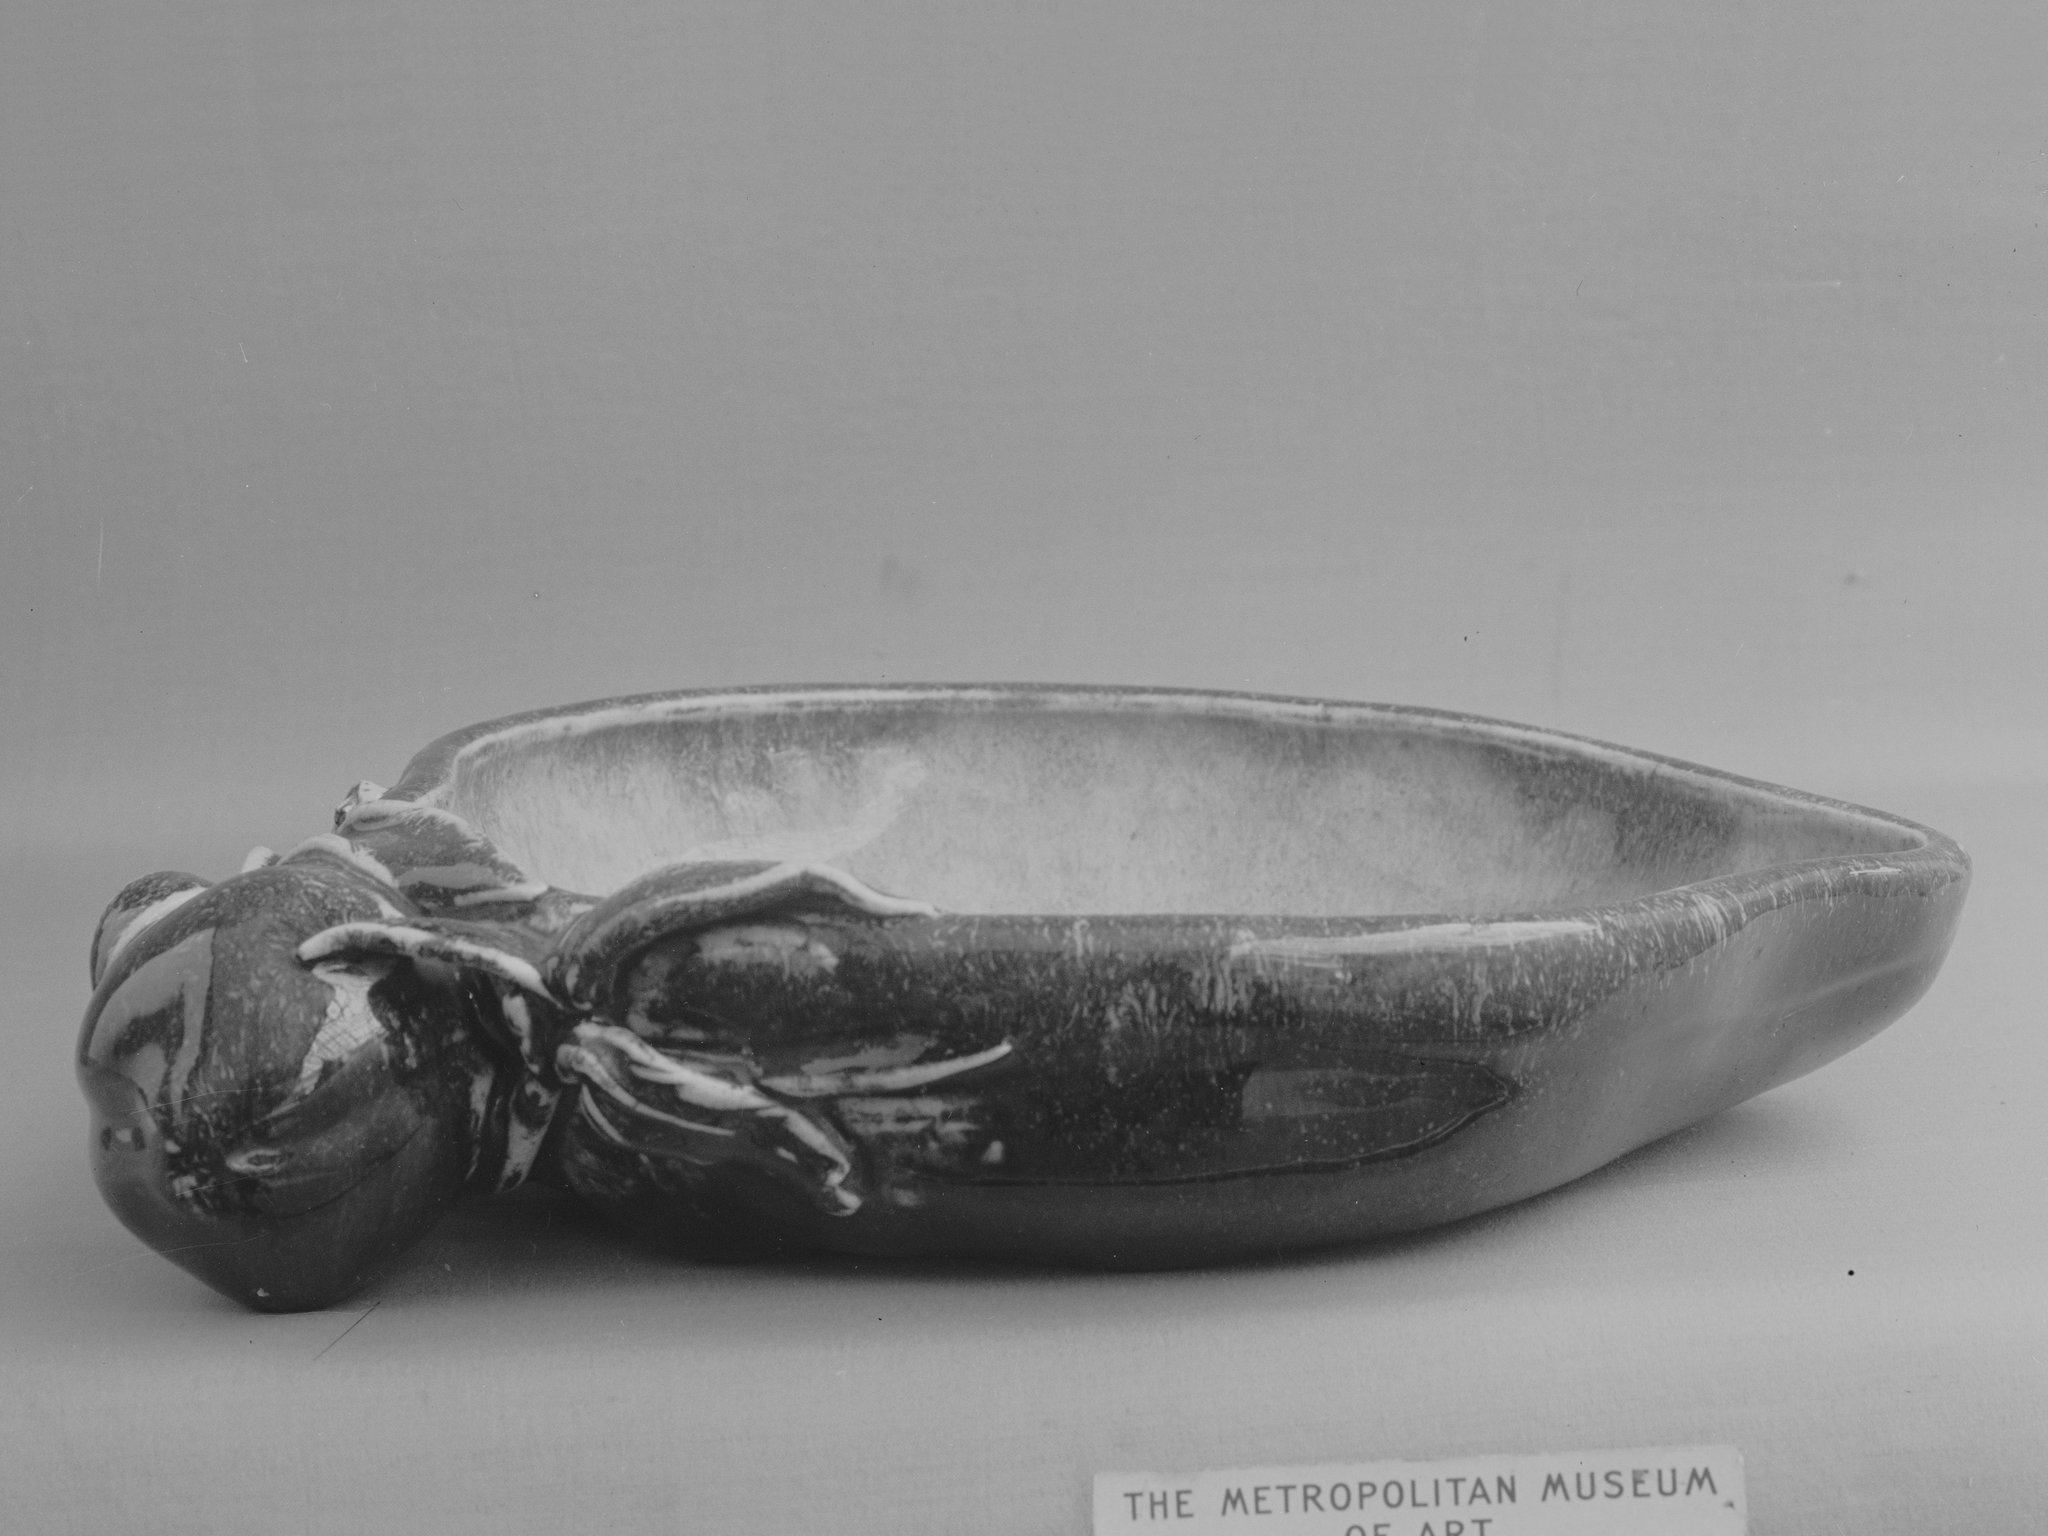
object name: brush washer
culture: chinese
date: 1767-1800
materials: glaze, stoneware